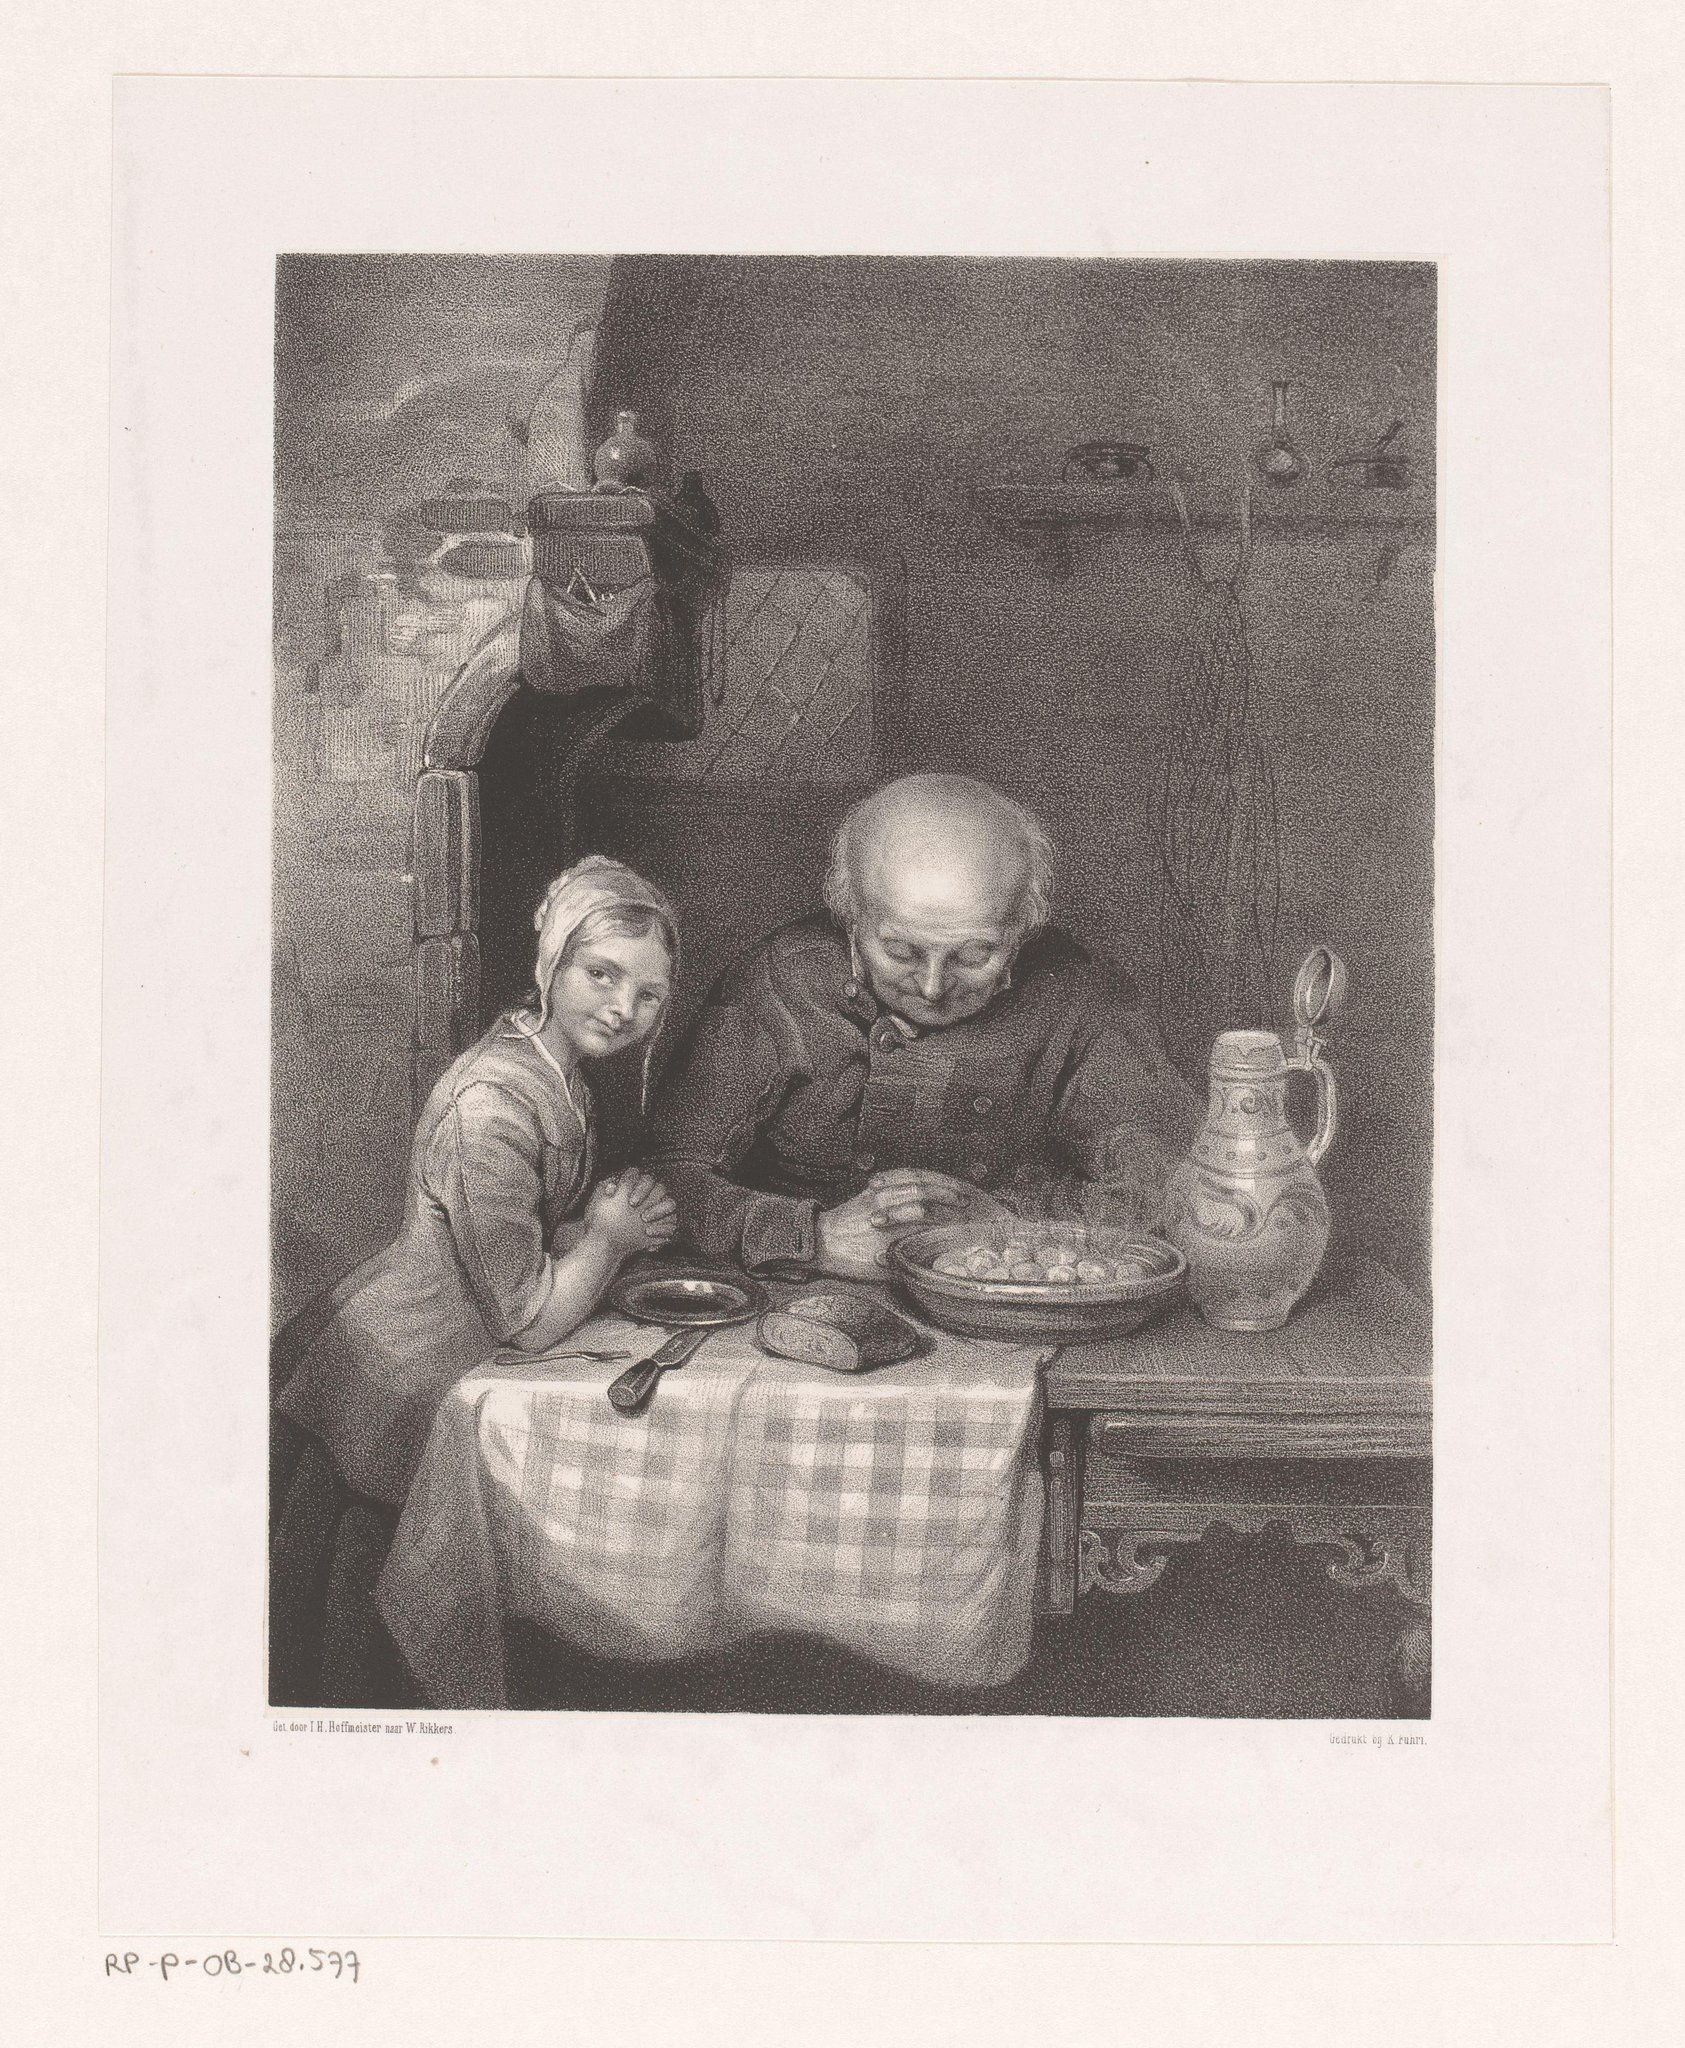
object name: print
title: Gebed aan tafel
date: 1843-1853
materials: paper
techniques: lithograph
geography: netherlands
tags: prayer at table, saying grace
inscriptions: collector's mark: Lugt 2228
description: Een man en meisje zitten aan tafel met hun handen gevouwen. De man is in gebed verzonken, het meisje kijkt op. Voor hen staat een warme maaltijd.